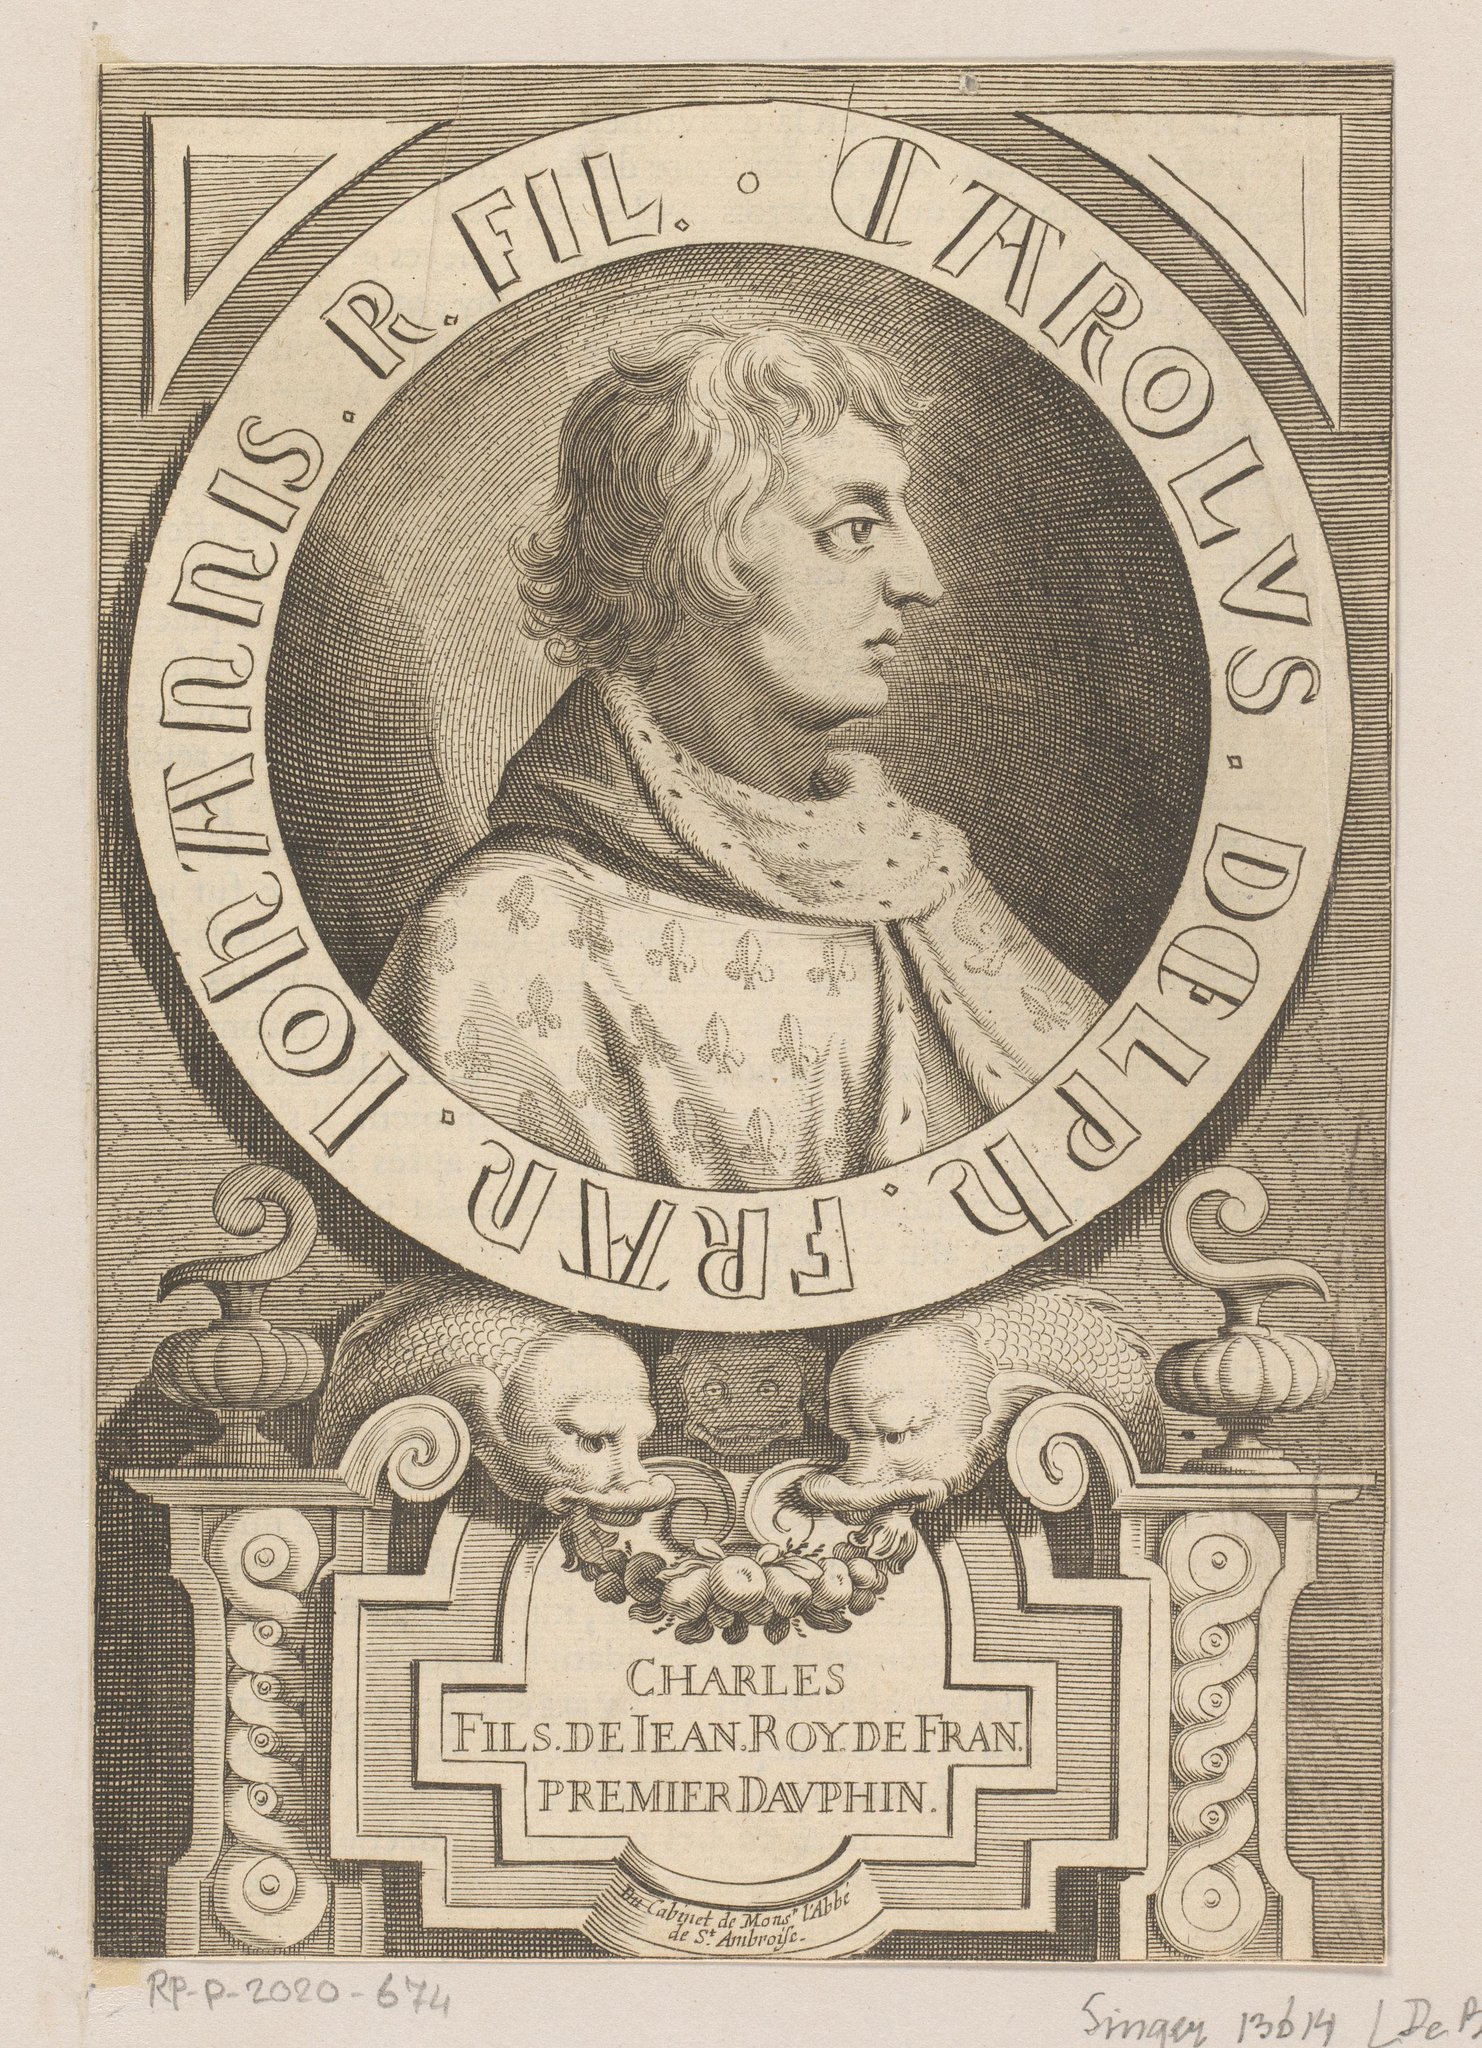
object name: print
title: Charles fils de Jean roy de Fran premier Dauphin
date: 1635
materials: paper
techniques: engraving, letterpress printing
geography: paris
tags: paris, historical persons, king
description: Prent uit: Eudes de Mézeray, François. Histoire de France, depuis Faramond jusqu’au regne de Louis le Juste (...). 3 dln. Parijs: Denis Thierry, Jean Guignard en Claude Barbin, 1635, dl. 2. Prent waarschijnlijk voor het eerst verschenen in: Bie, Jacques de. Les vrais portraits des rois de France (...). Parijs: Jacques de Bie en Pierre Rocolet, 1634. Prent ook gebruikt in latere publicaties.